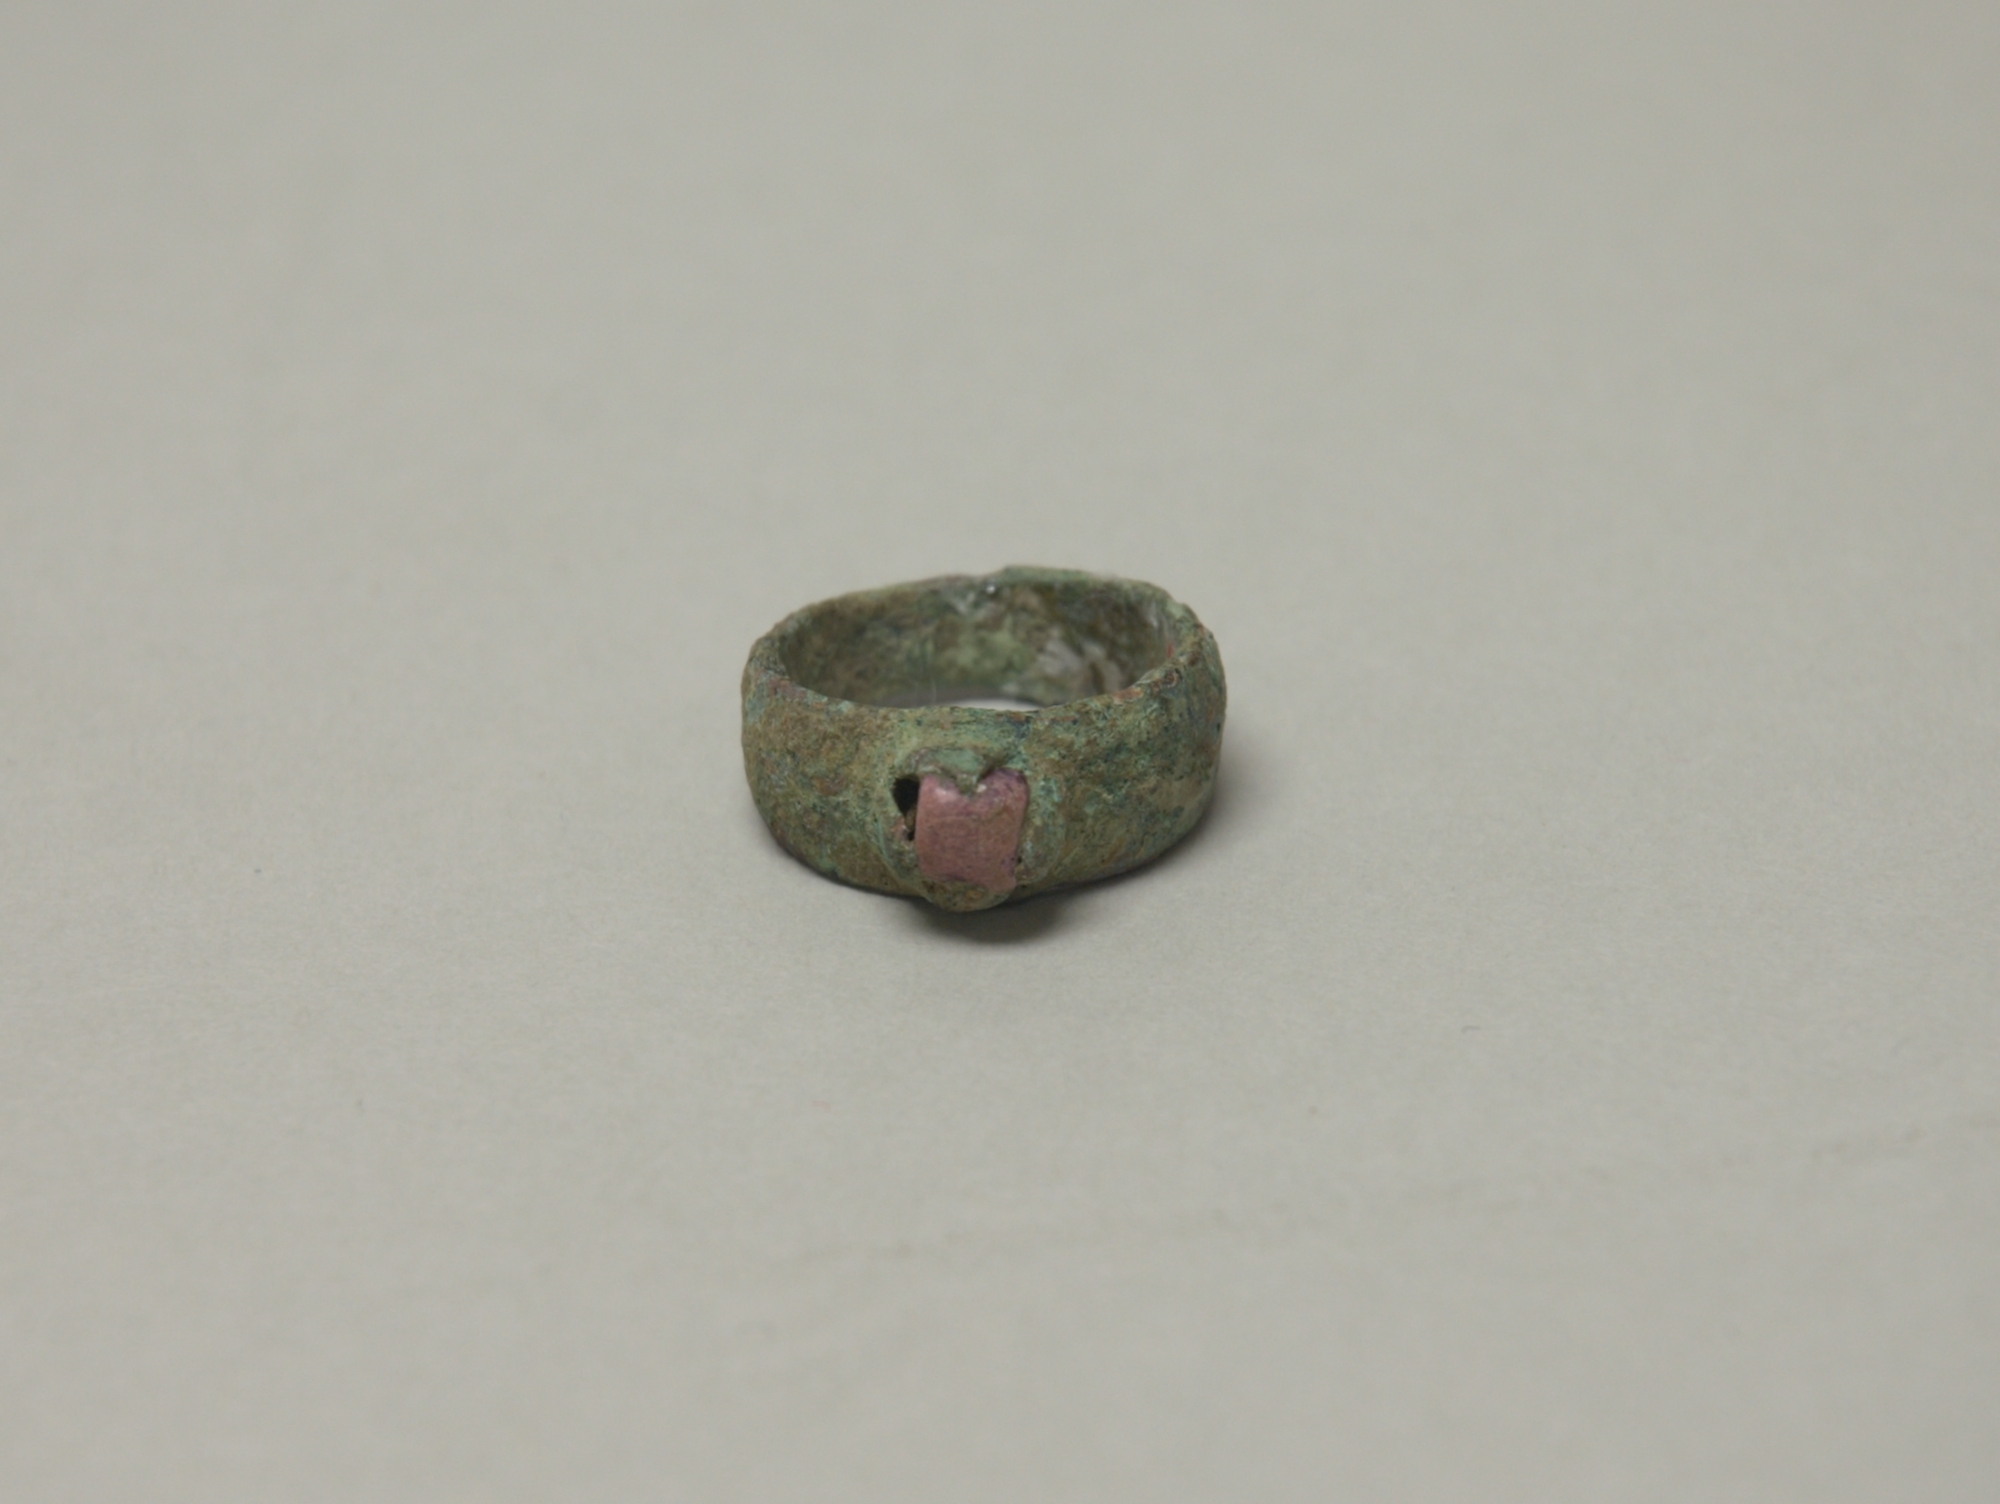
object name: ring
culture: thai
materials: bronze